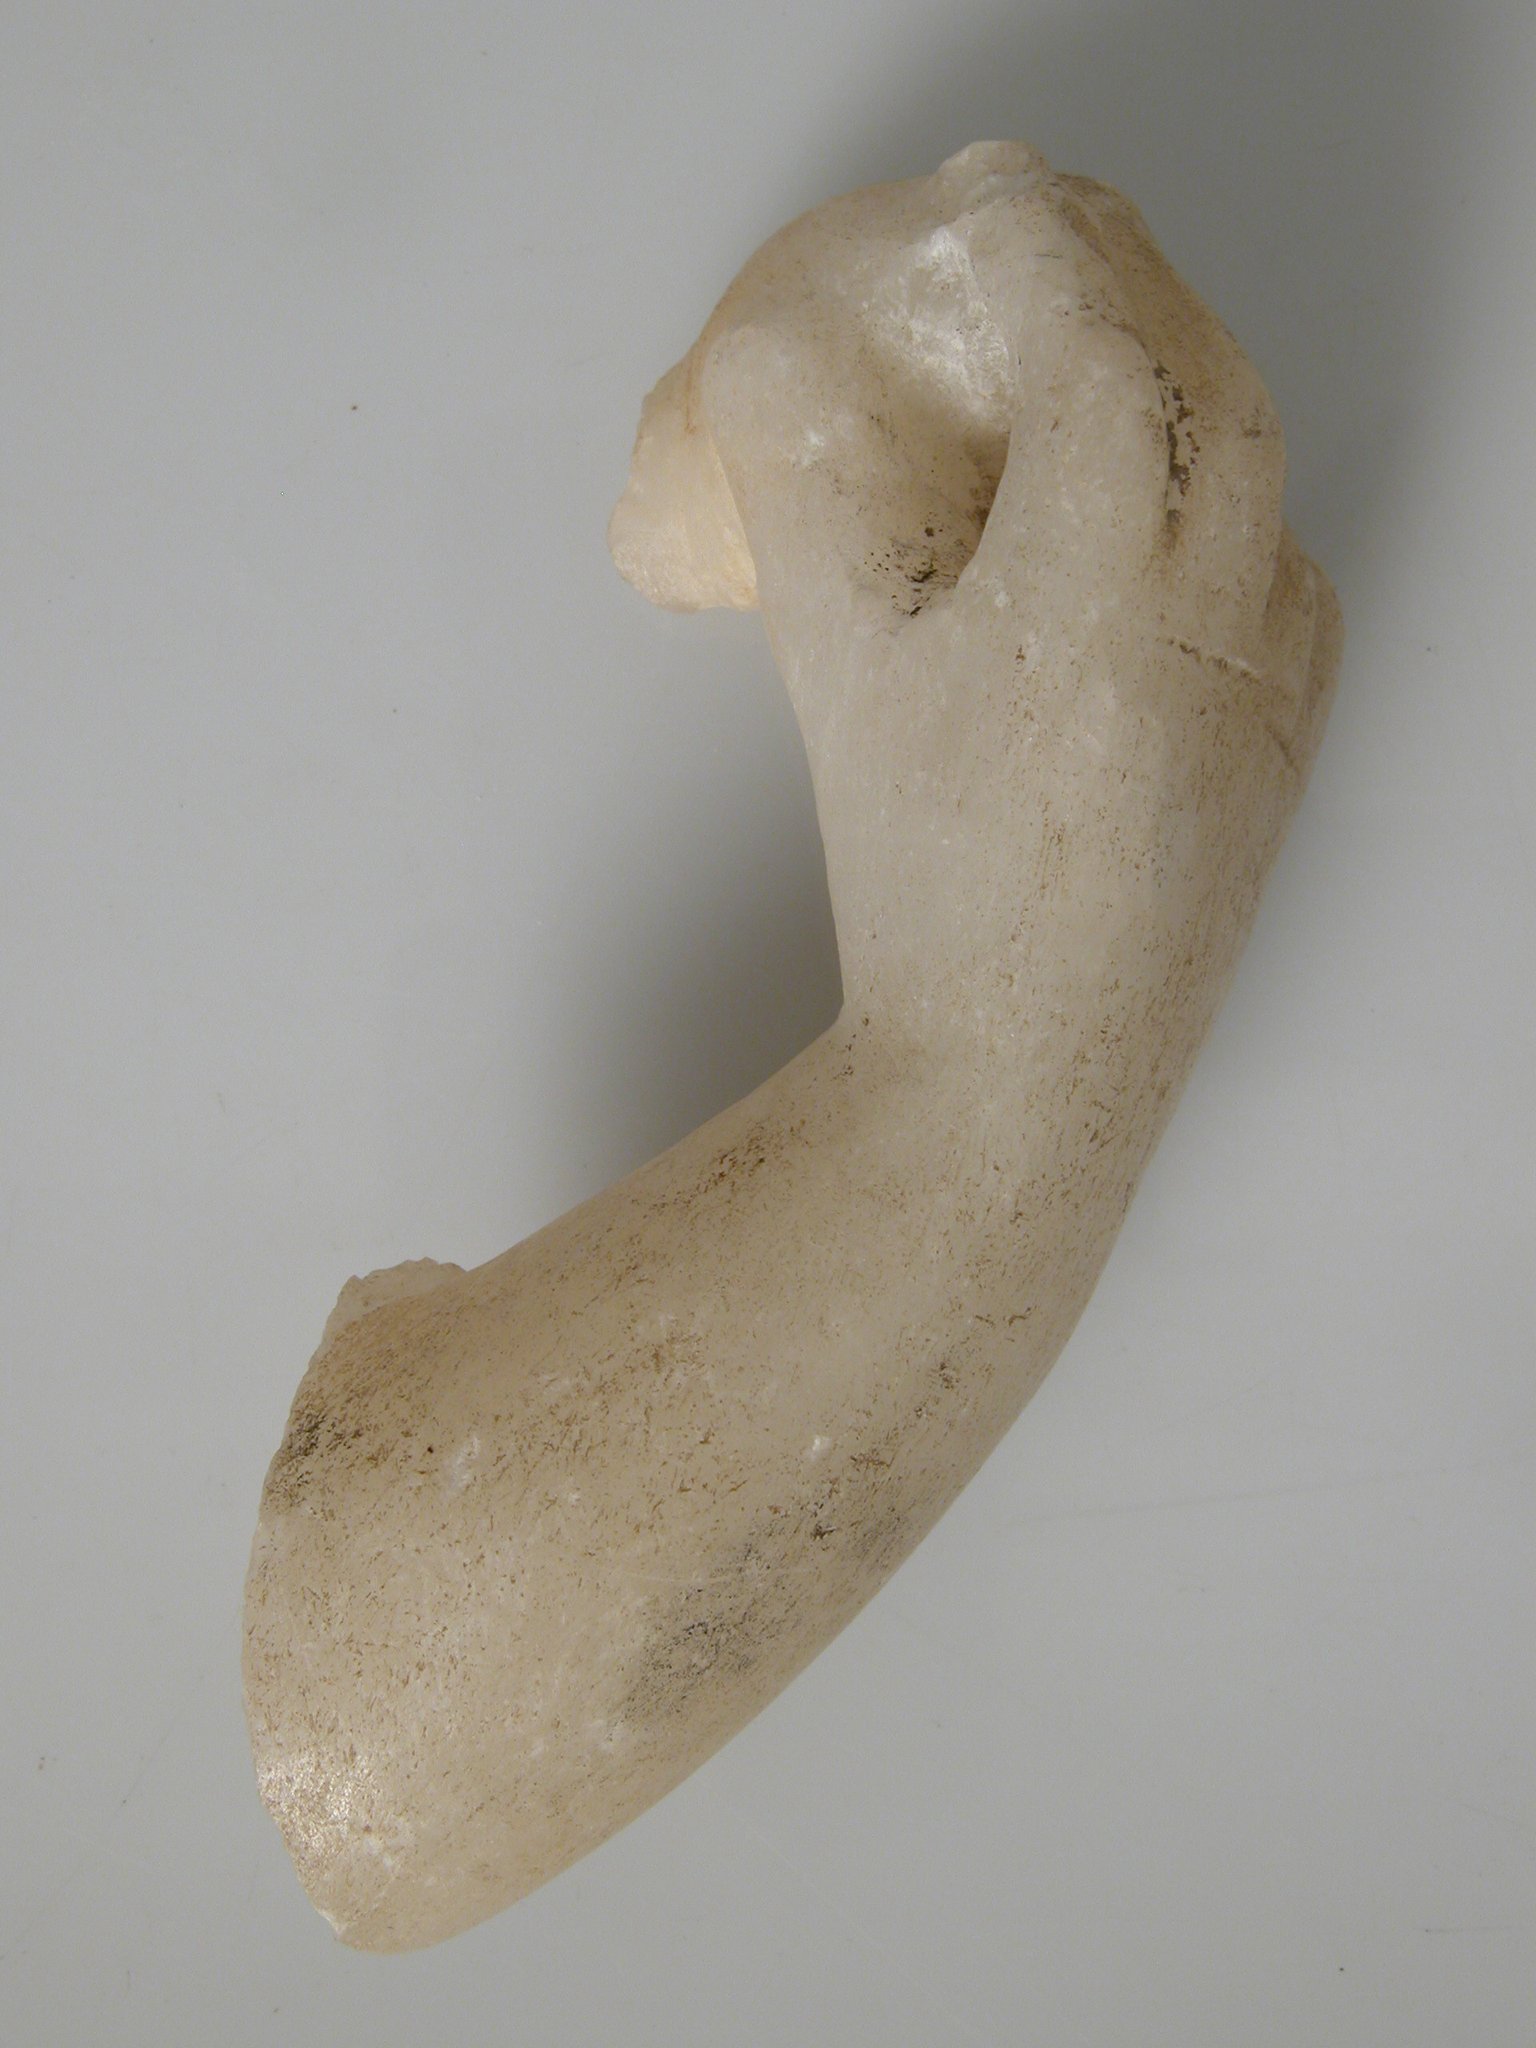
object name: statuette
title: Arm and Hand Fragment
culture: coptic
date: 301-700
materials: marble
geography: egypt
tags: hands